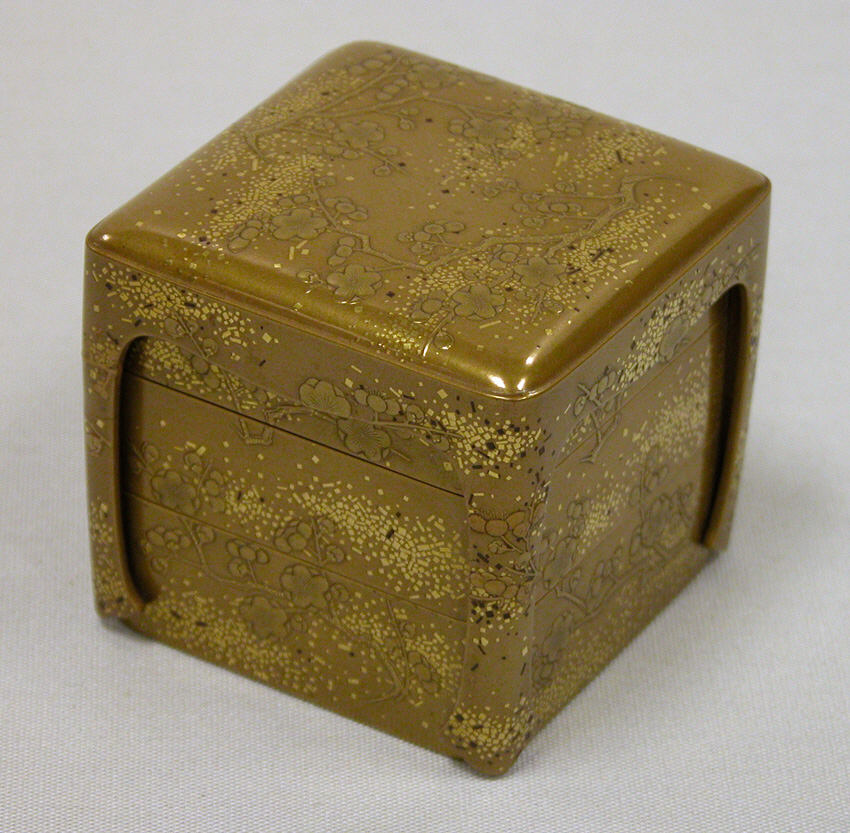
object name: box in three section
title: Box in three sections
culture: japanese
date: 1701-1900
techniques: kirikane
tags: flowers,plants